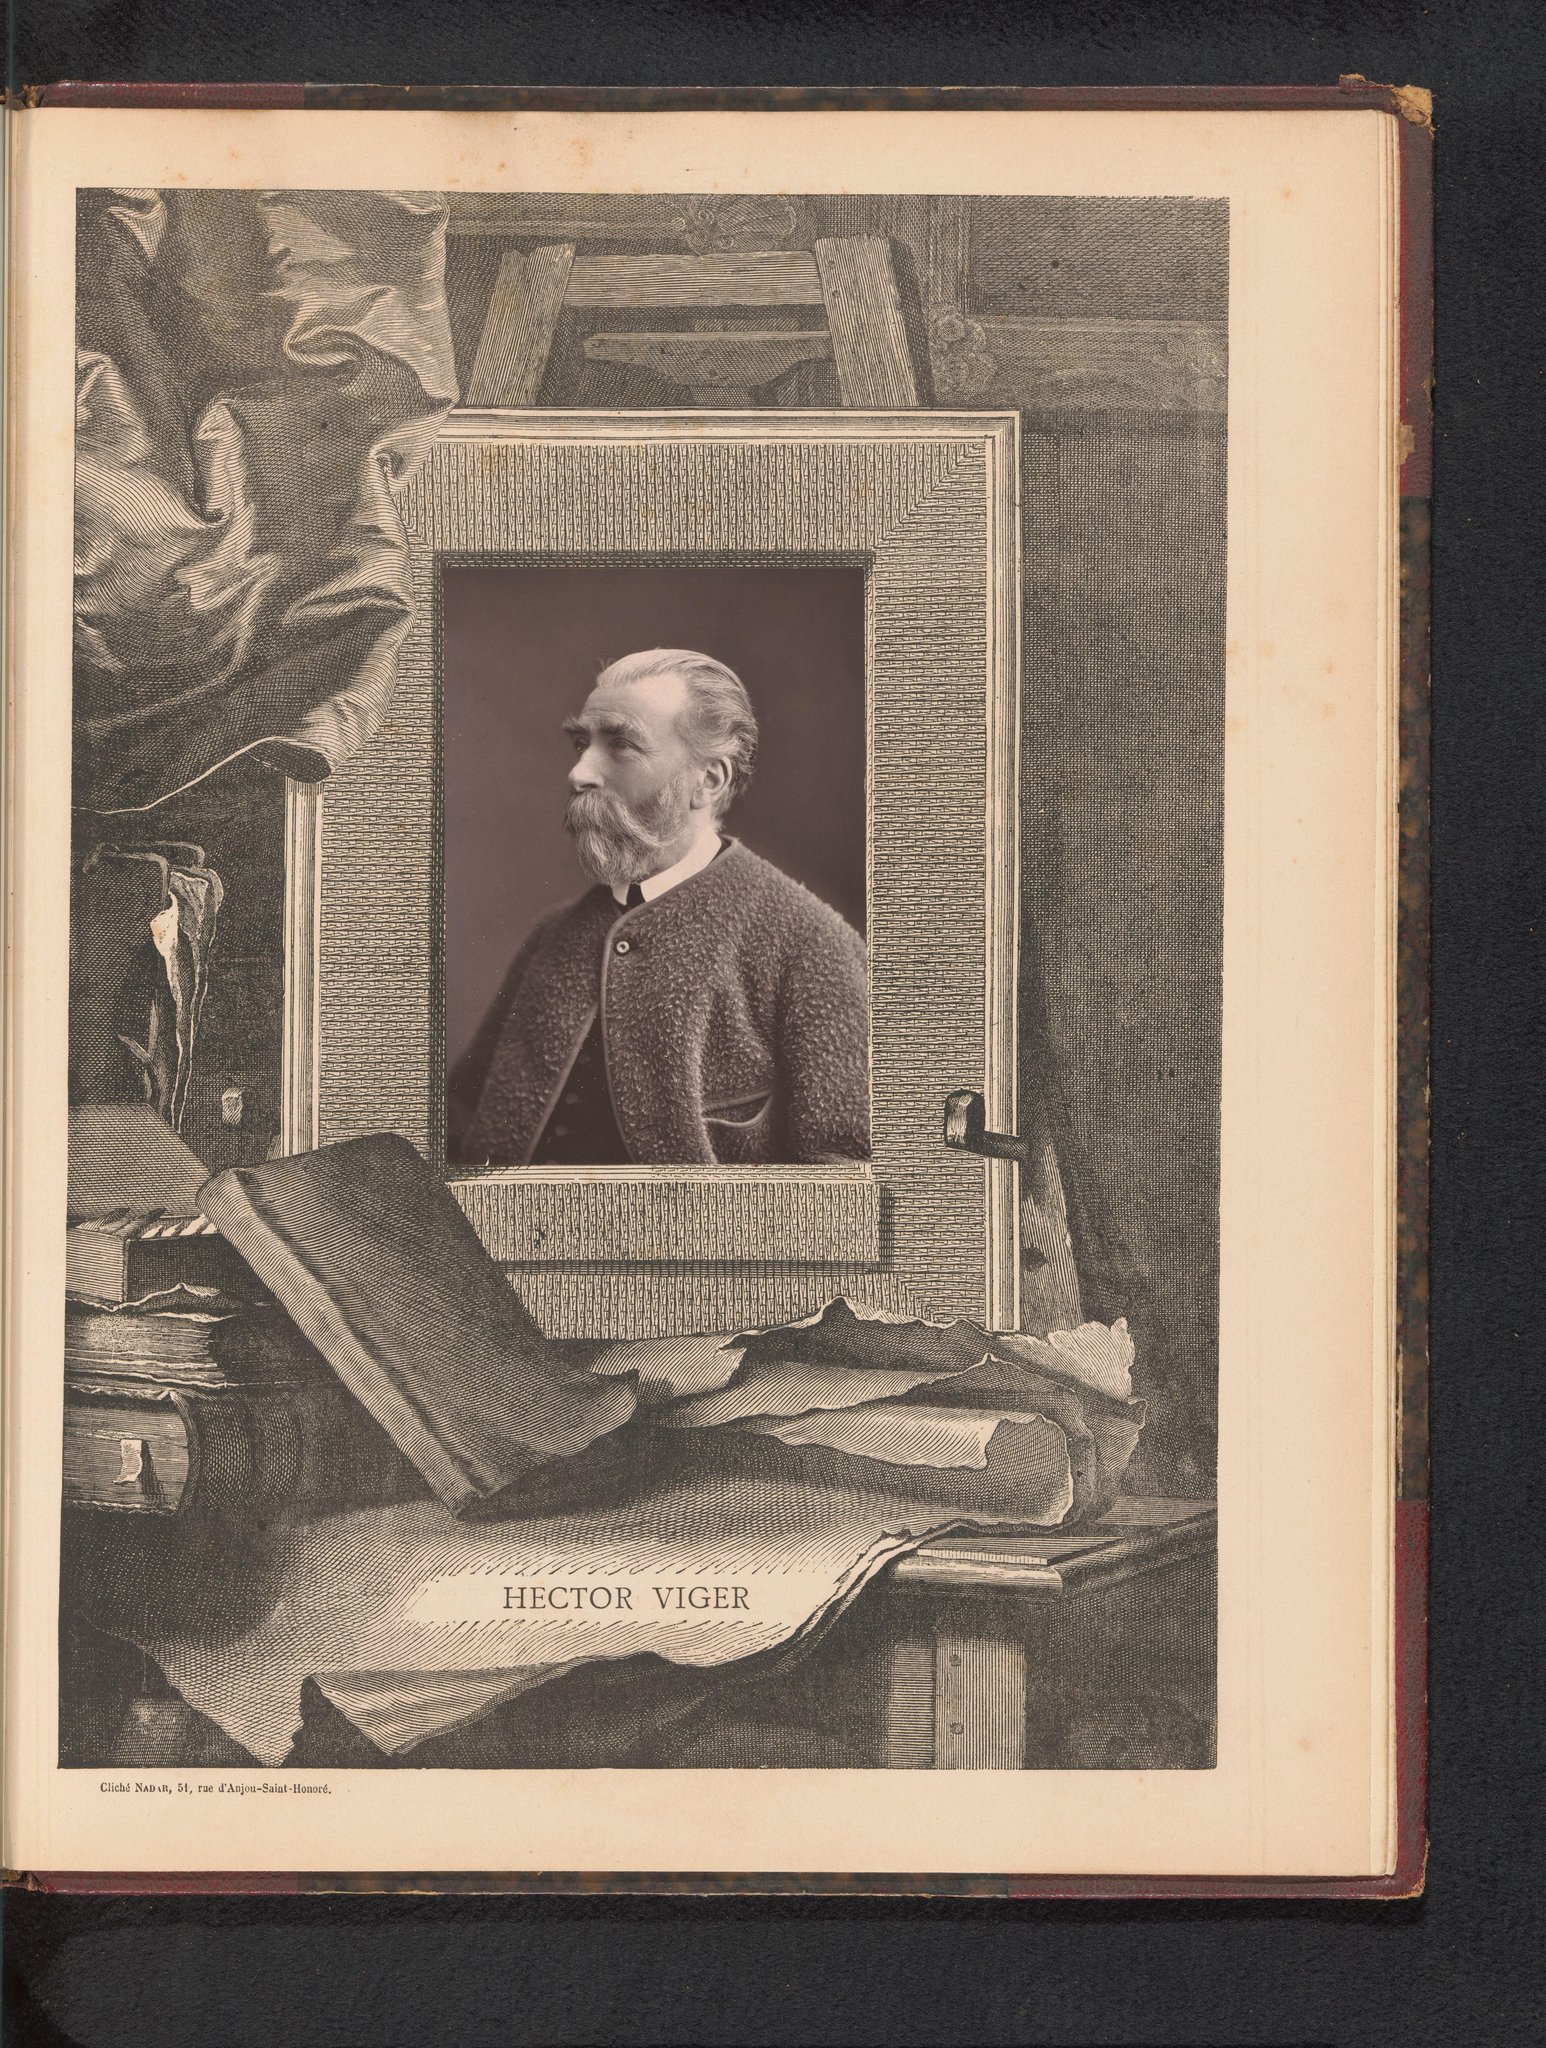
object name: page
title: Hector Viger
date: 1871-1876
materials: paper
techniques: woodburytype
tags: hector viger, adult man, historical persons